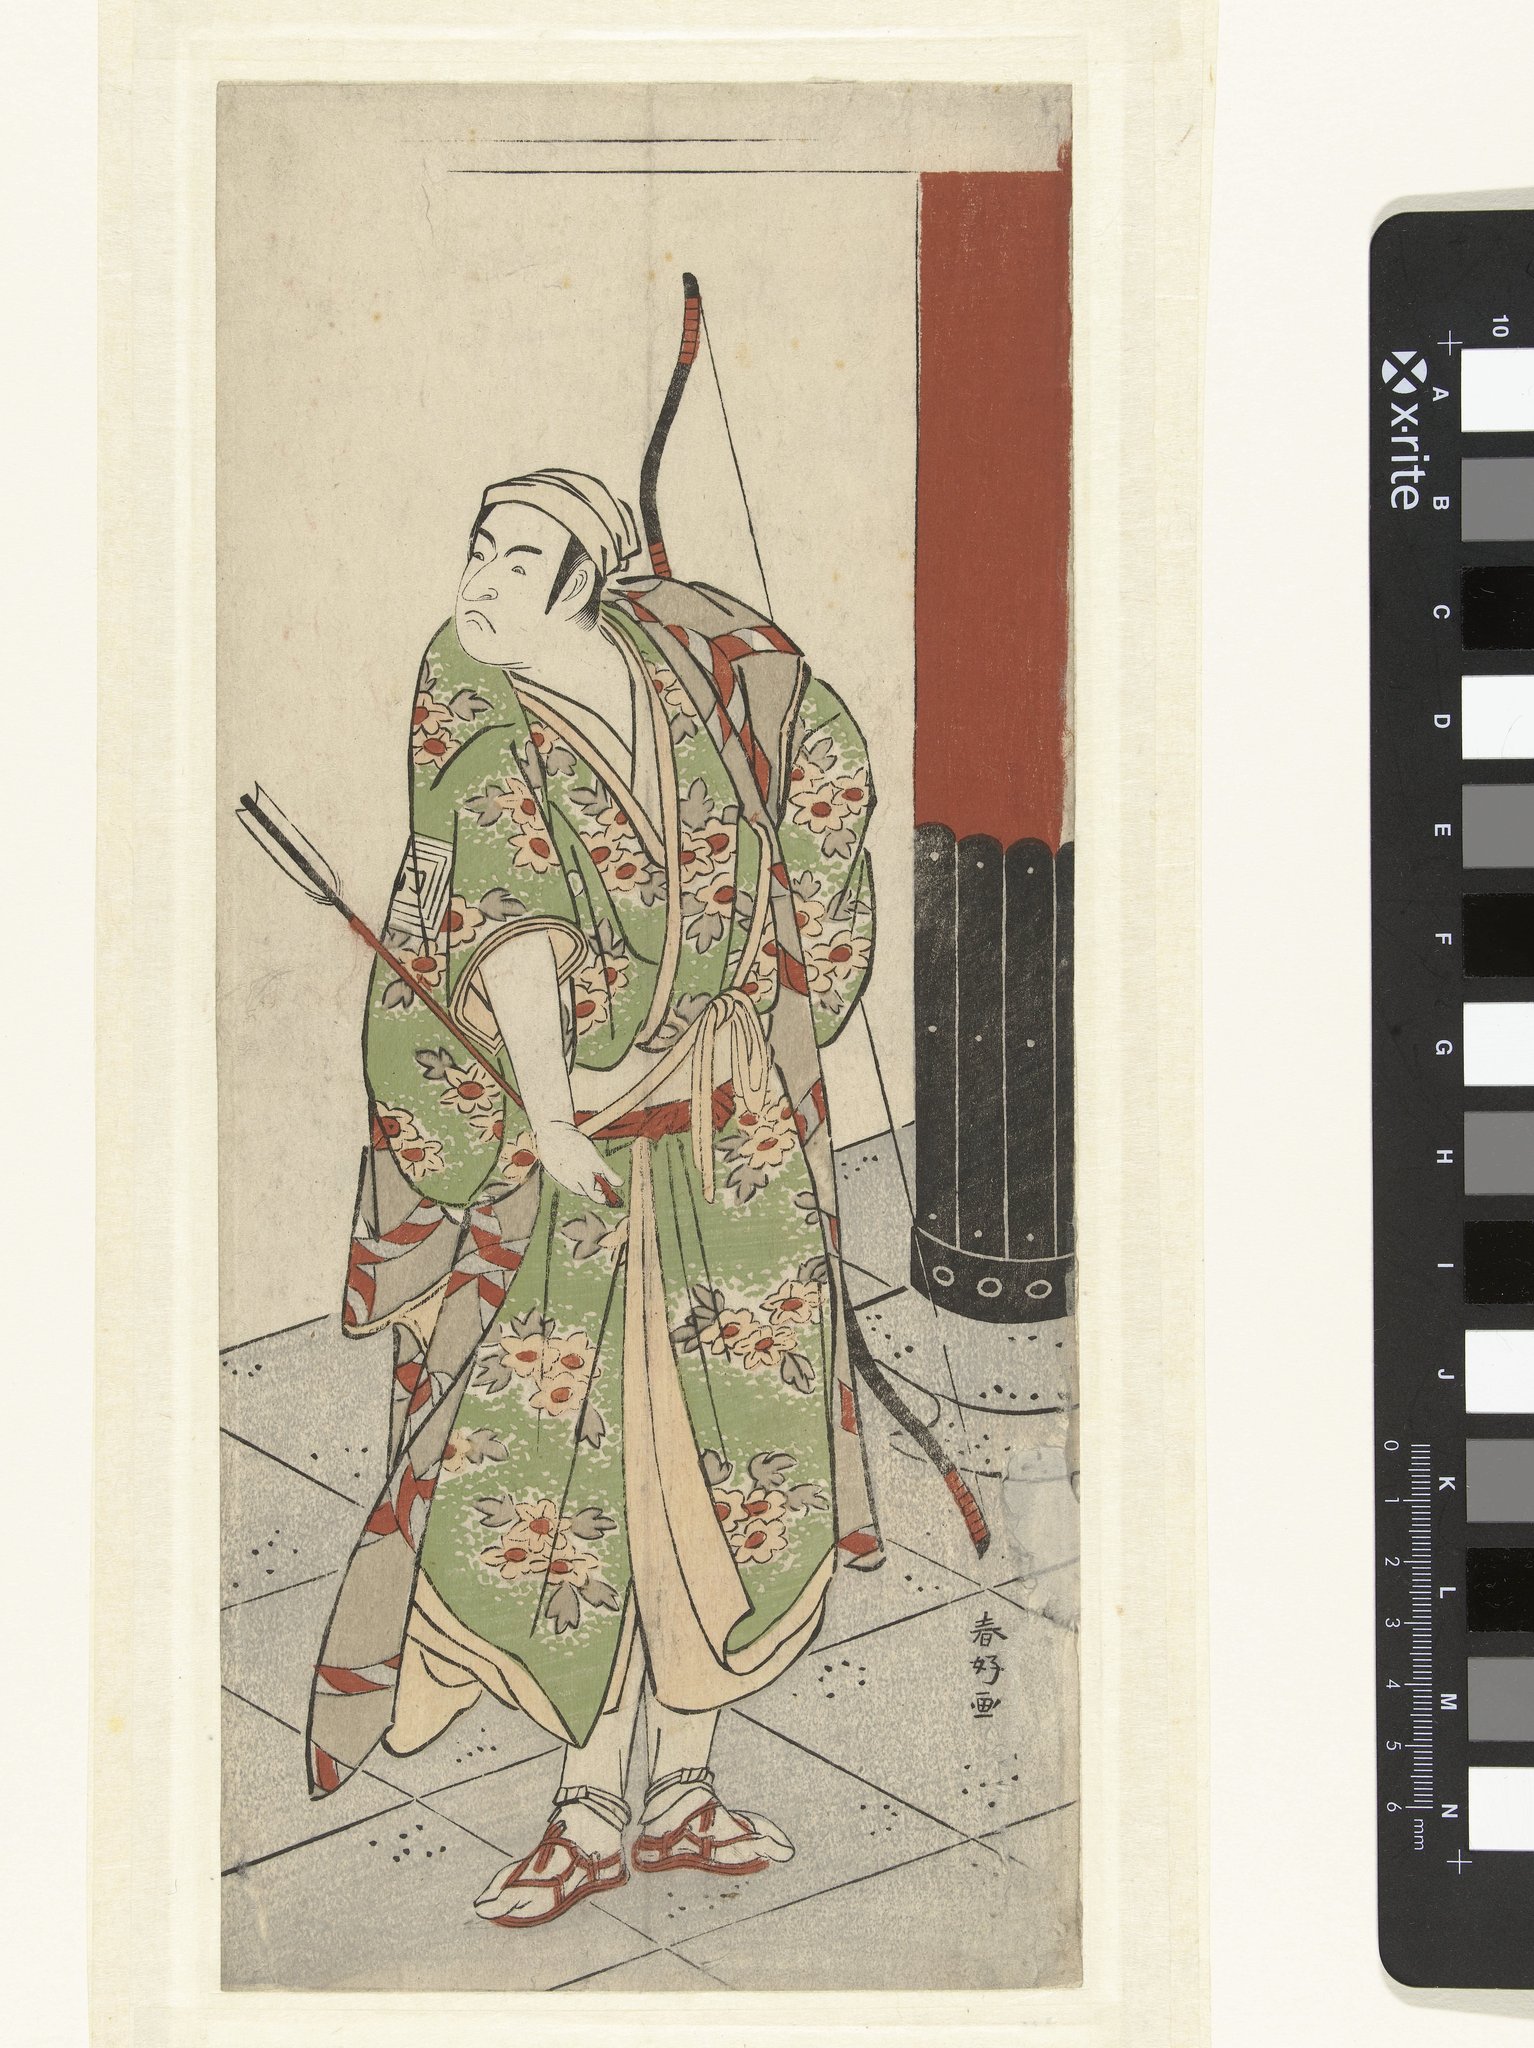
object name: print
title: Acteur Ichikawa Monnosuke II met pijl en boog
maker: katsukawa shunko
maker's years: 1743-1812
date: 1780-1785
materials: paper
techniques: woodcut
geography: japan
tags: archer's weapons: bow and arrow, portrait of actor, actress